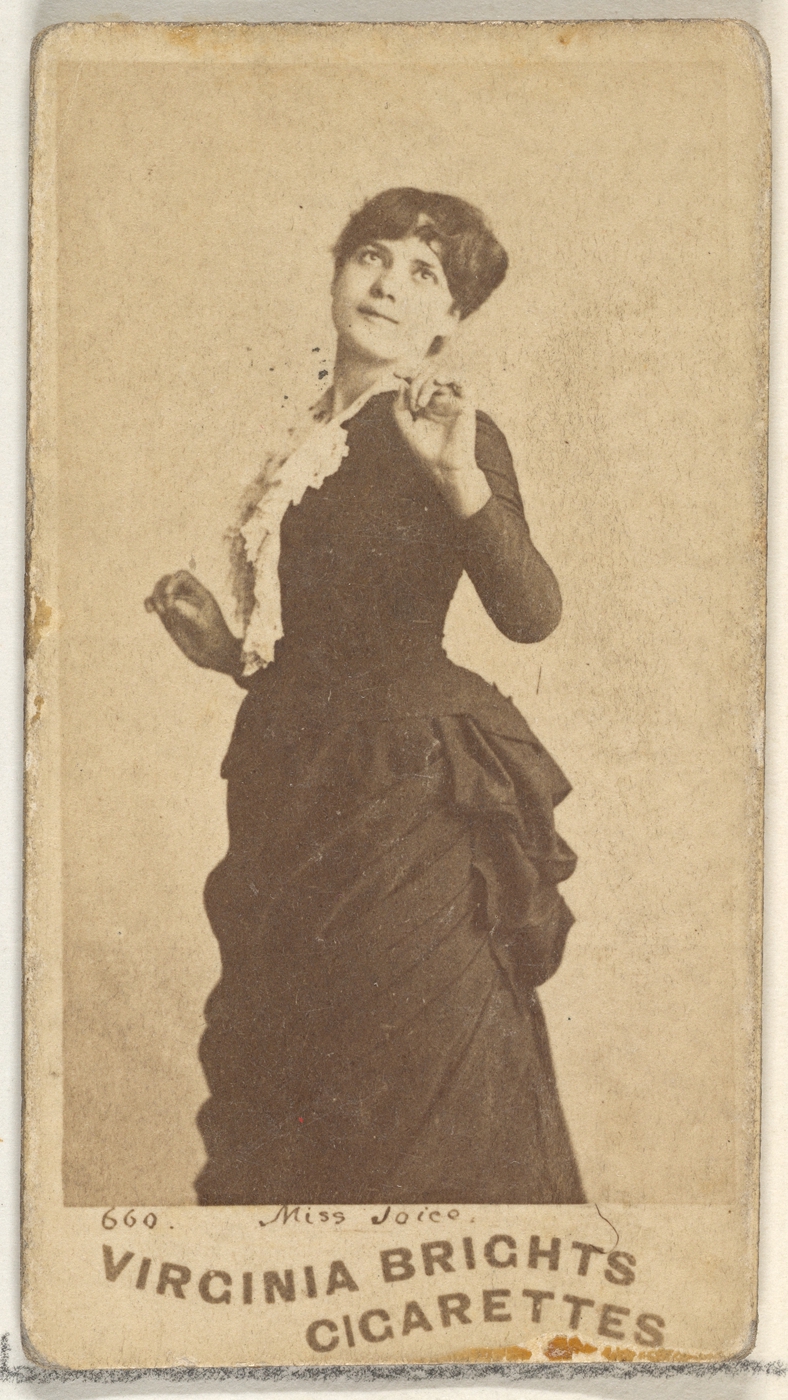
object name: photograph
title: Card 660, Miss Joice, from the Actors and Actresses series (N45, Type 1) for Virginia Brights Cigarettes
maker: allen & ginter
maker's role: publisher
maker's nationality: american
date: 1888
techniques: albumen silver print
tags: portraits,women,actresses